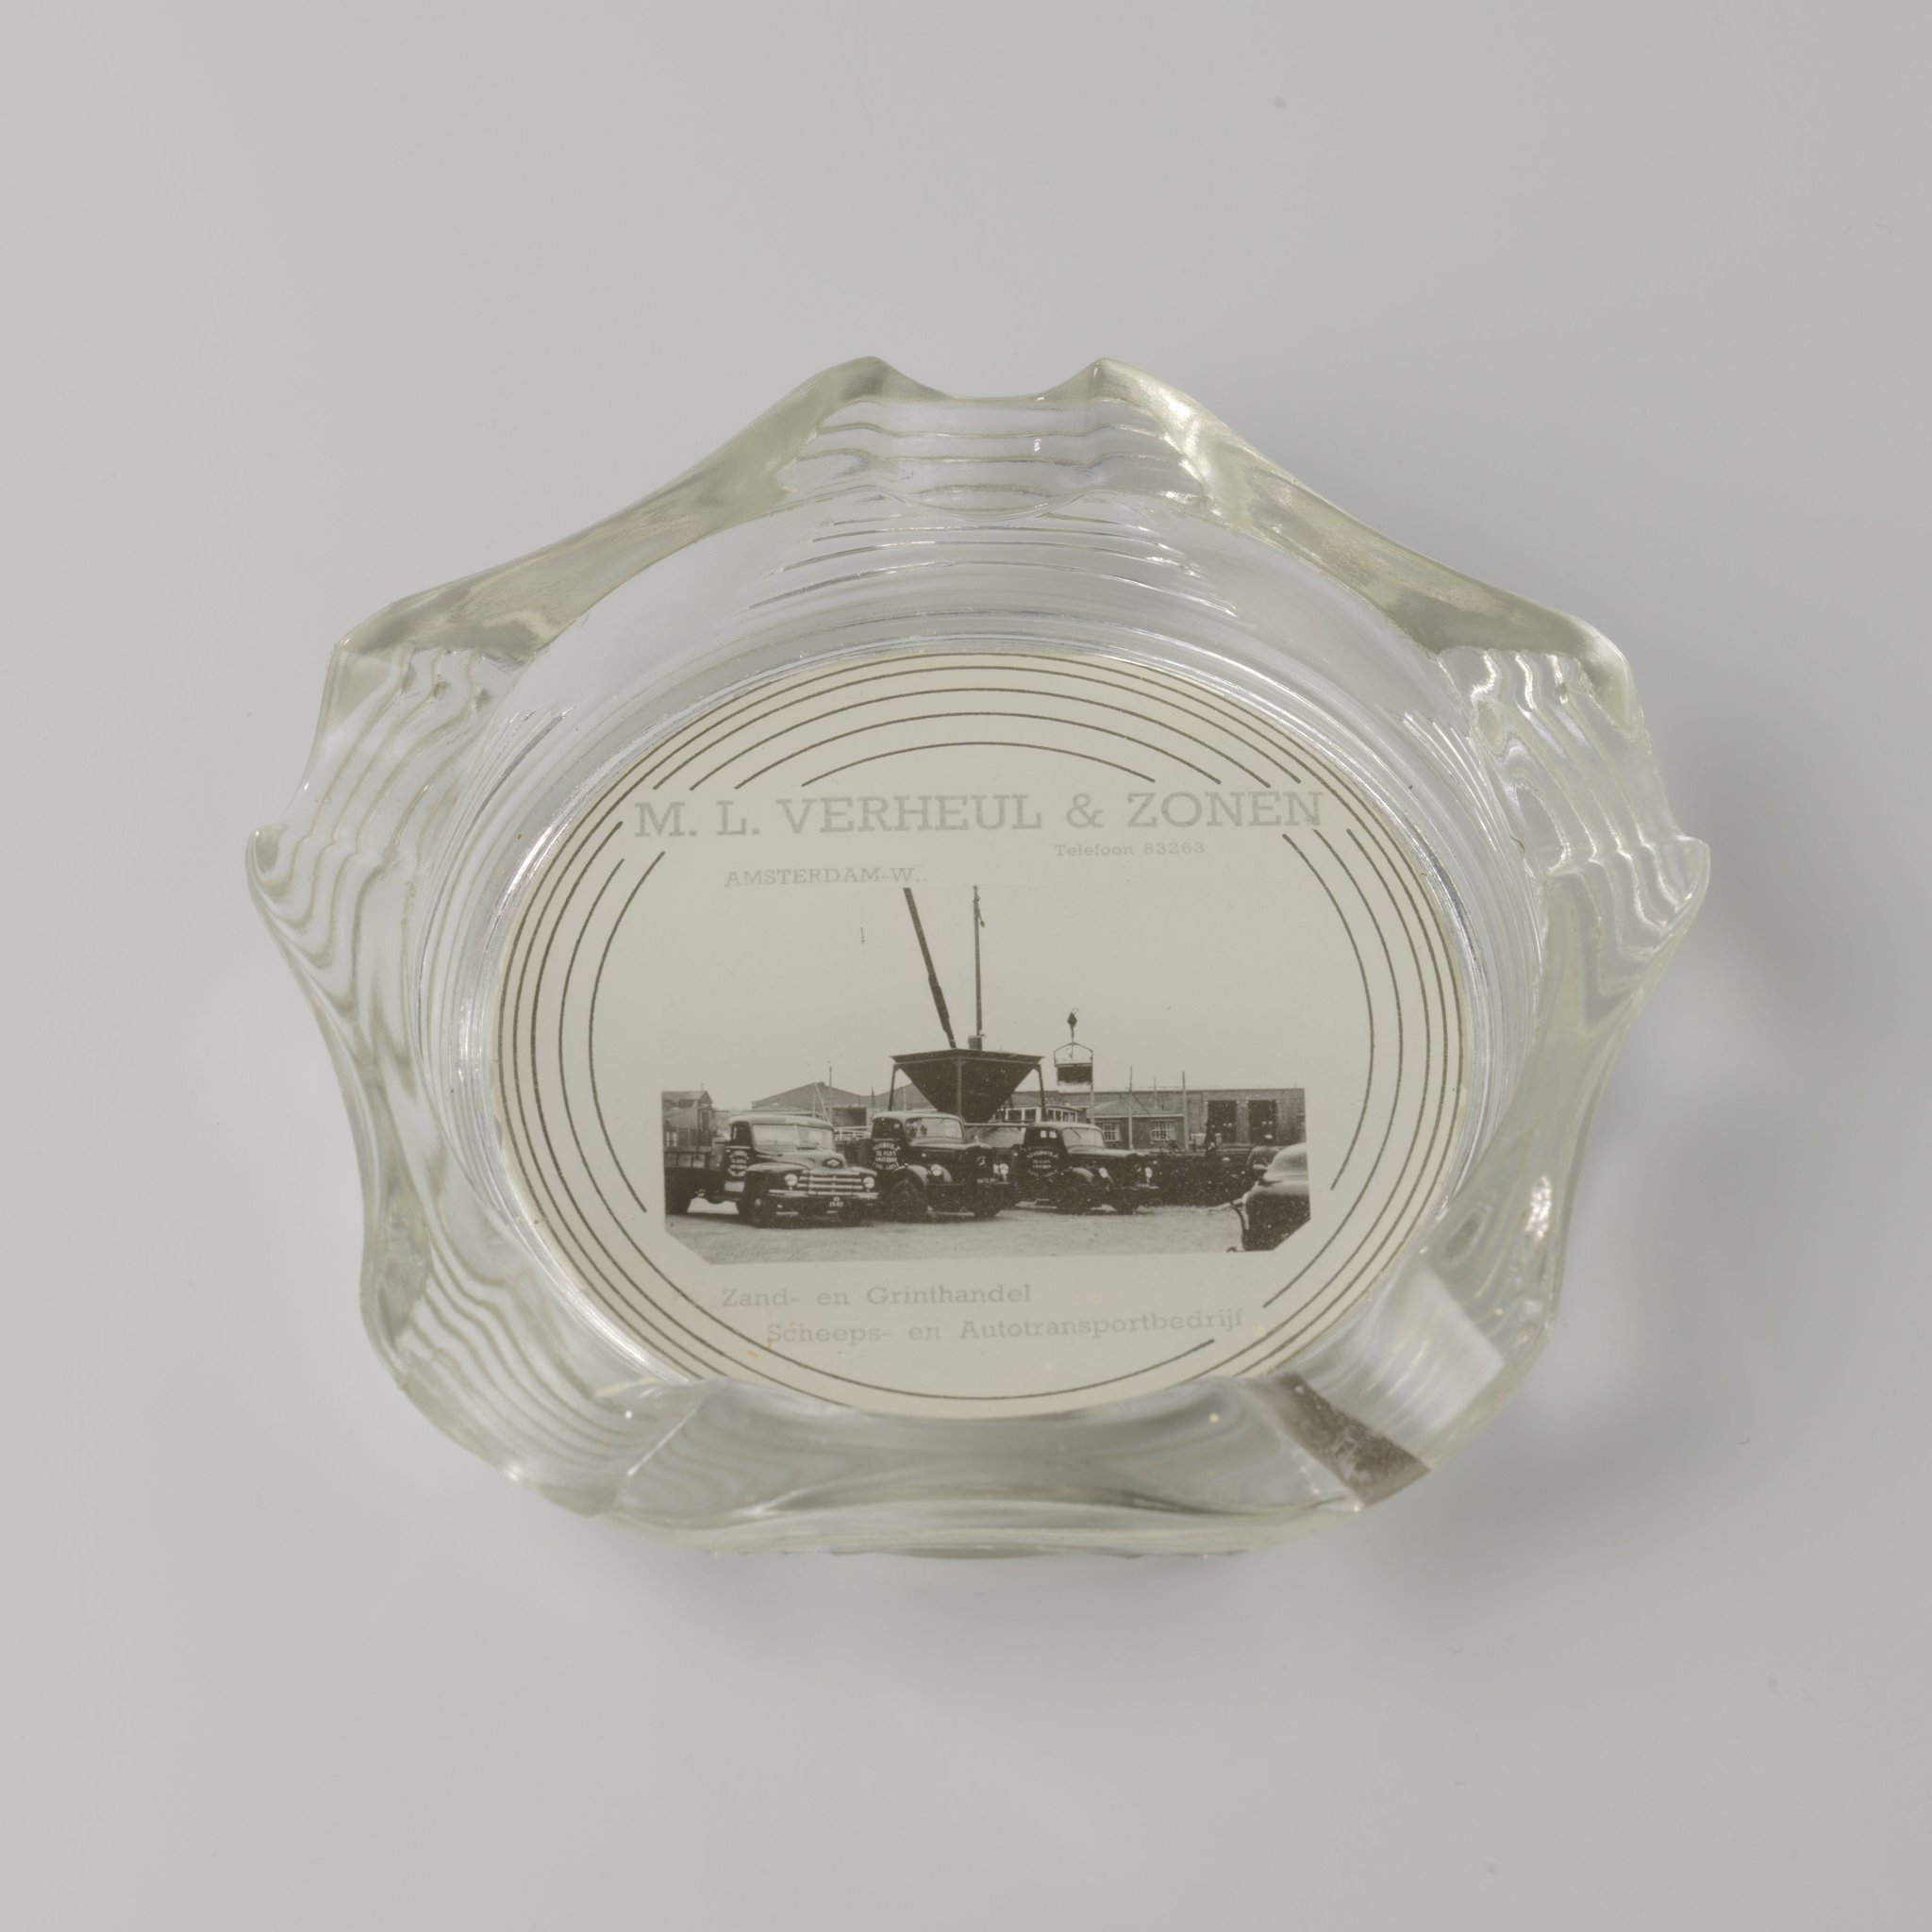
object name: ashtray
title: Asbak 'M.L. Verheul & Zonen / Amsterdam / Zand- en grinthandel [etc.]' (relatiegeschenk?)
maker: Anonymous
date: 1950-1960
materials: glass